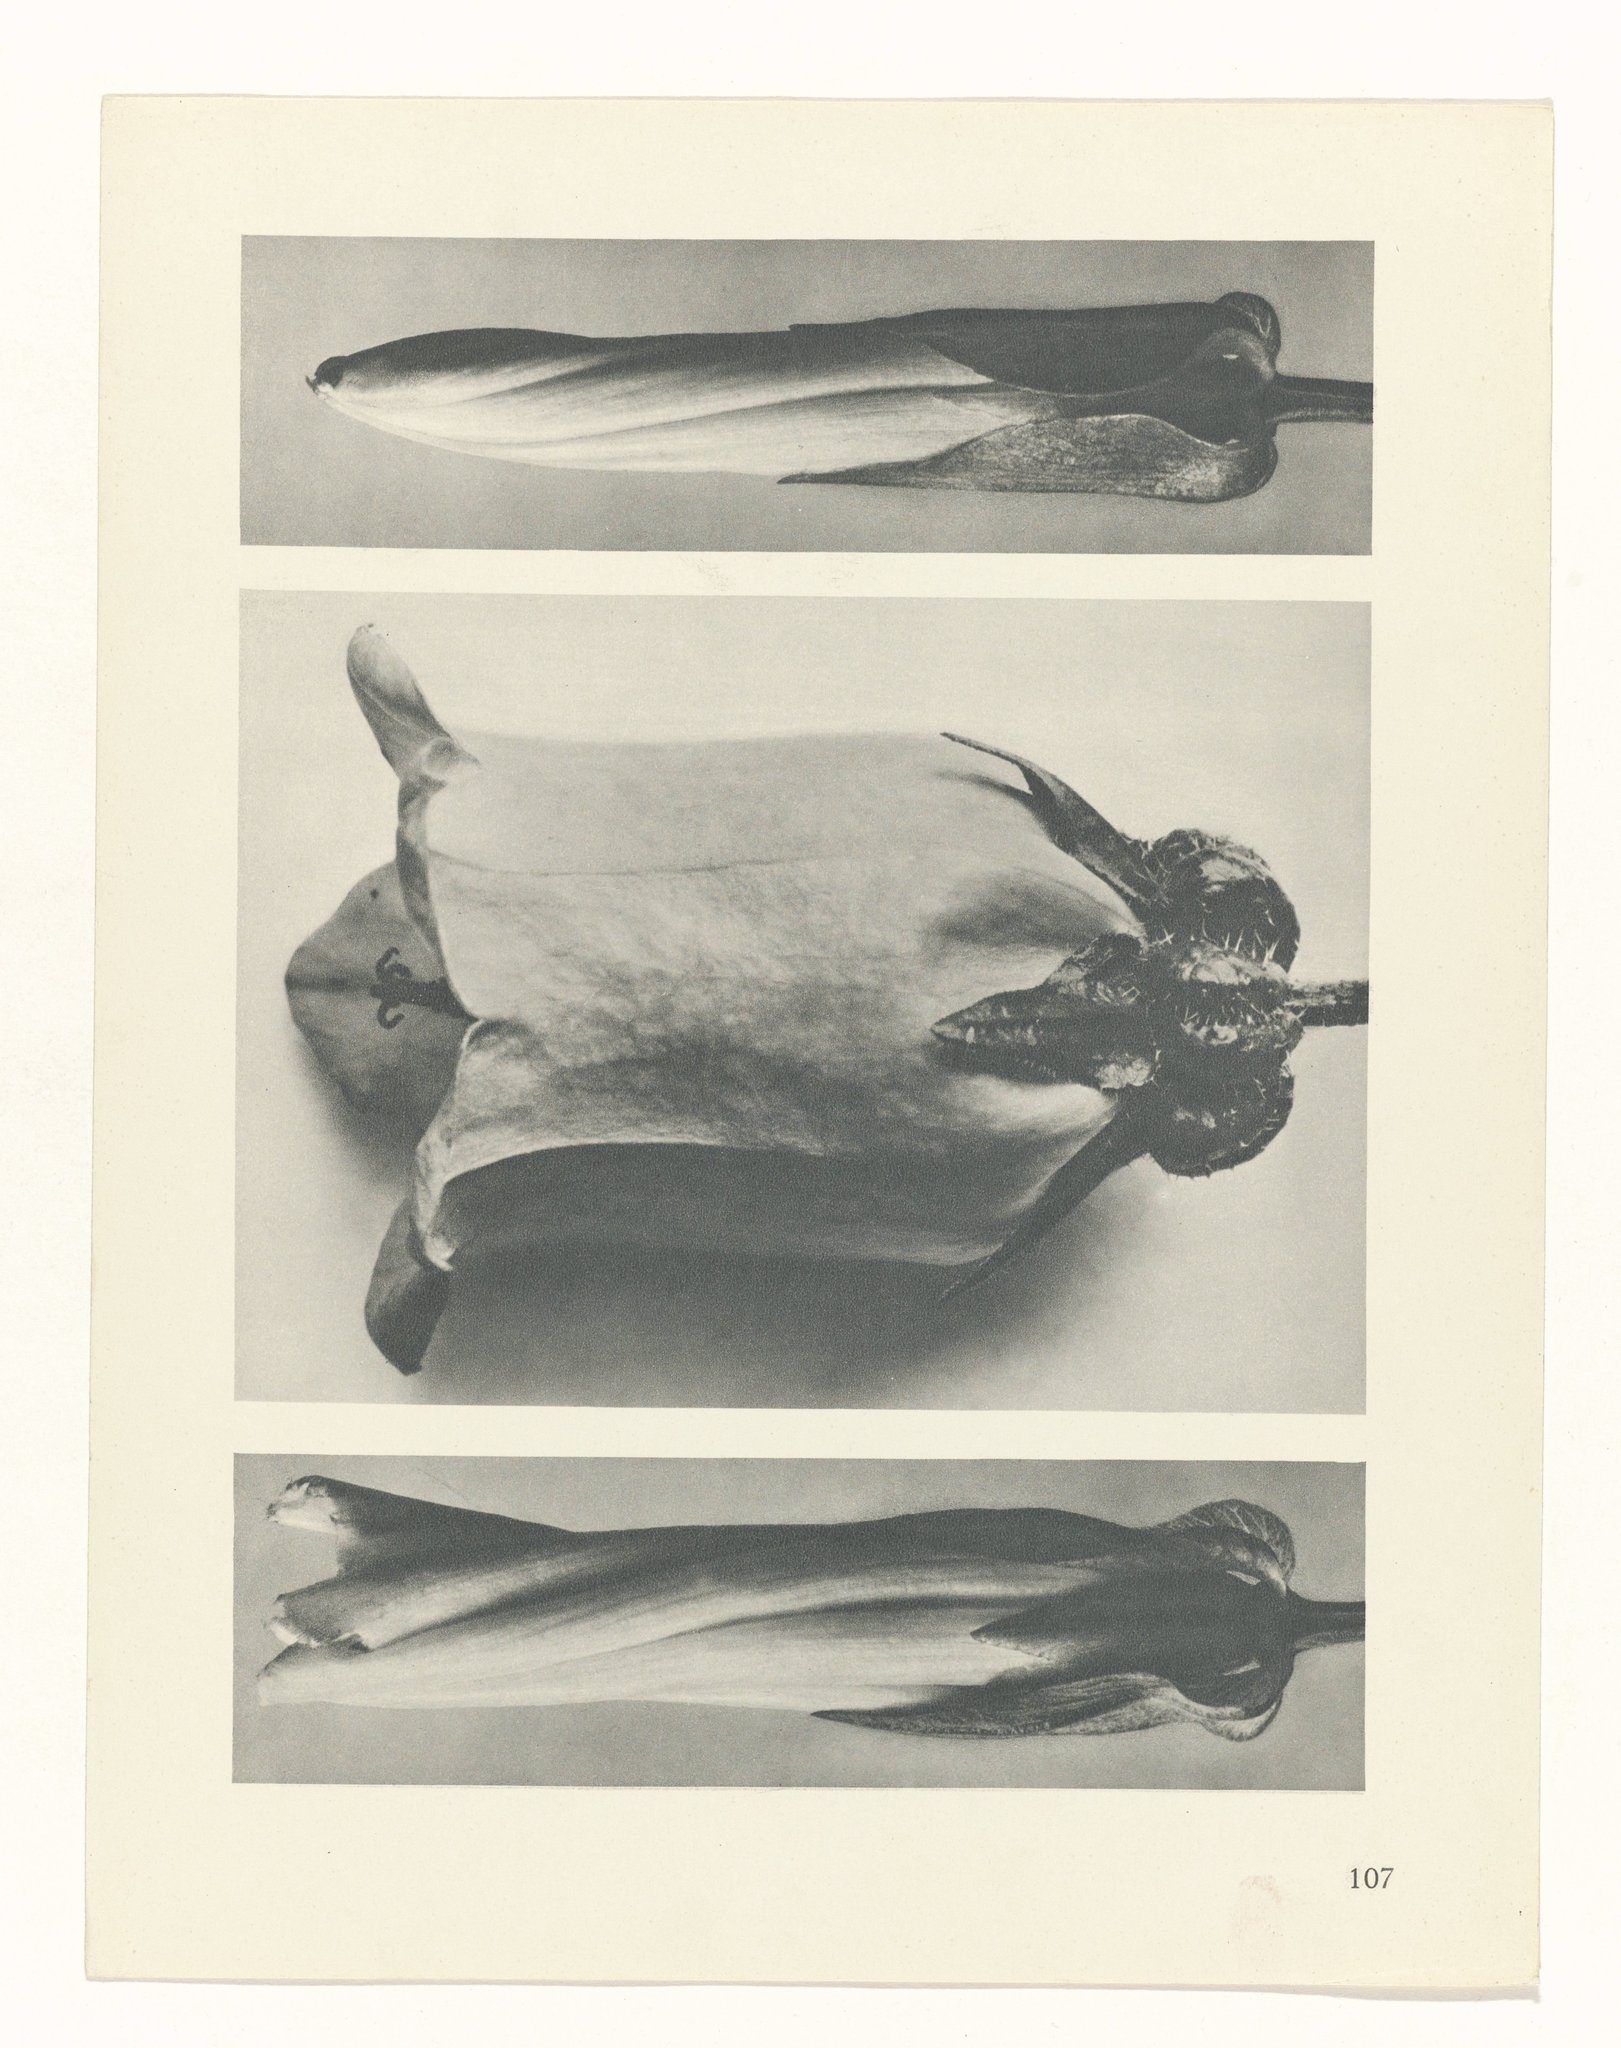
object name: photograph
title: Urformen der Kunst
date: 1928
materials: ink, paper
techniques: rotogravure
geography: berlin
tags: plants (in general)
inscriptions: number: ‘107’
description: facher Vergrößerung. Afkomstig uit losbladige uitgave.